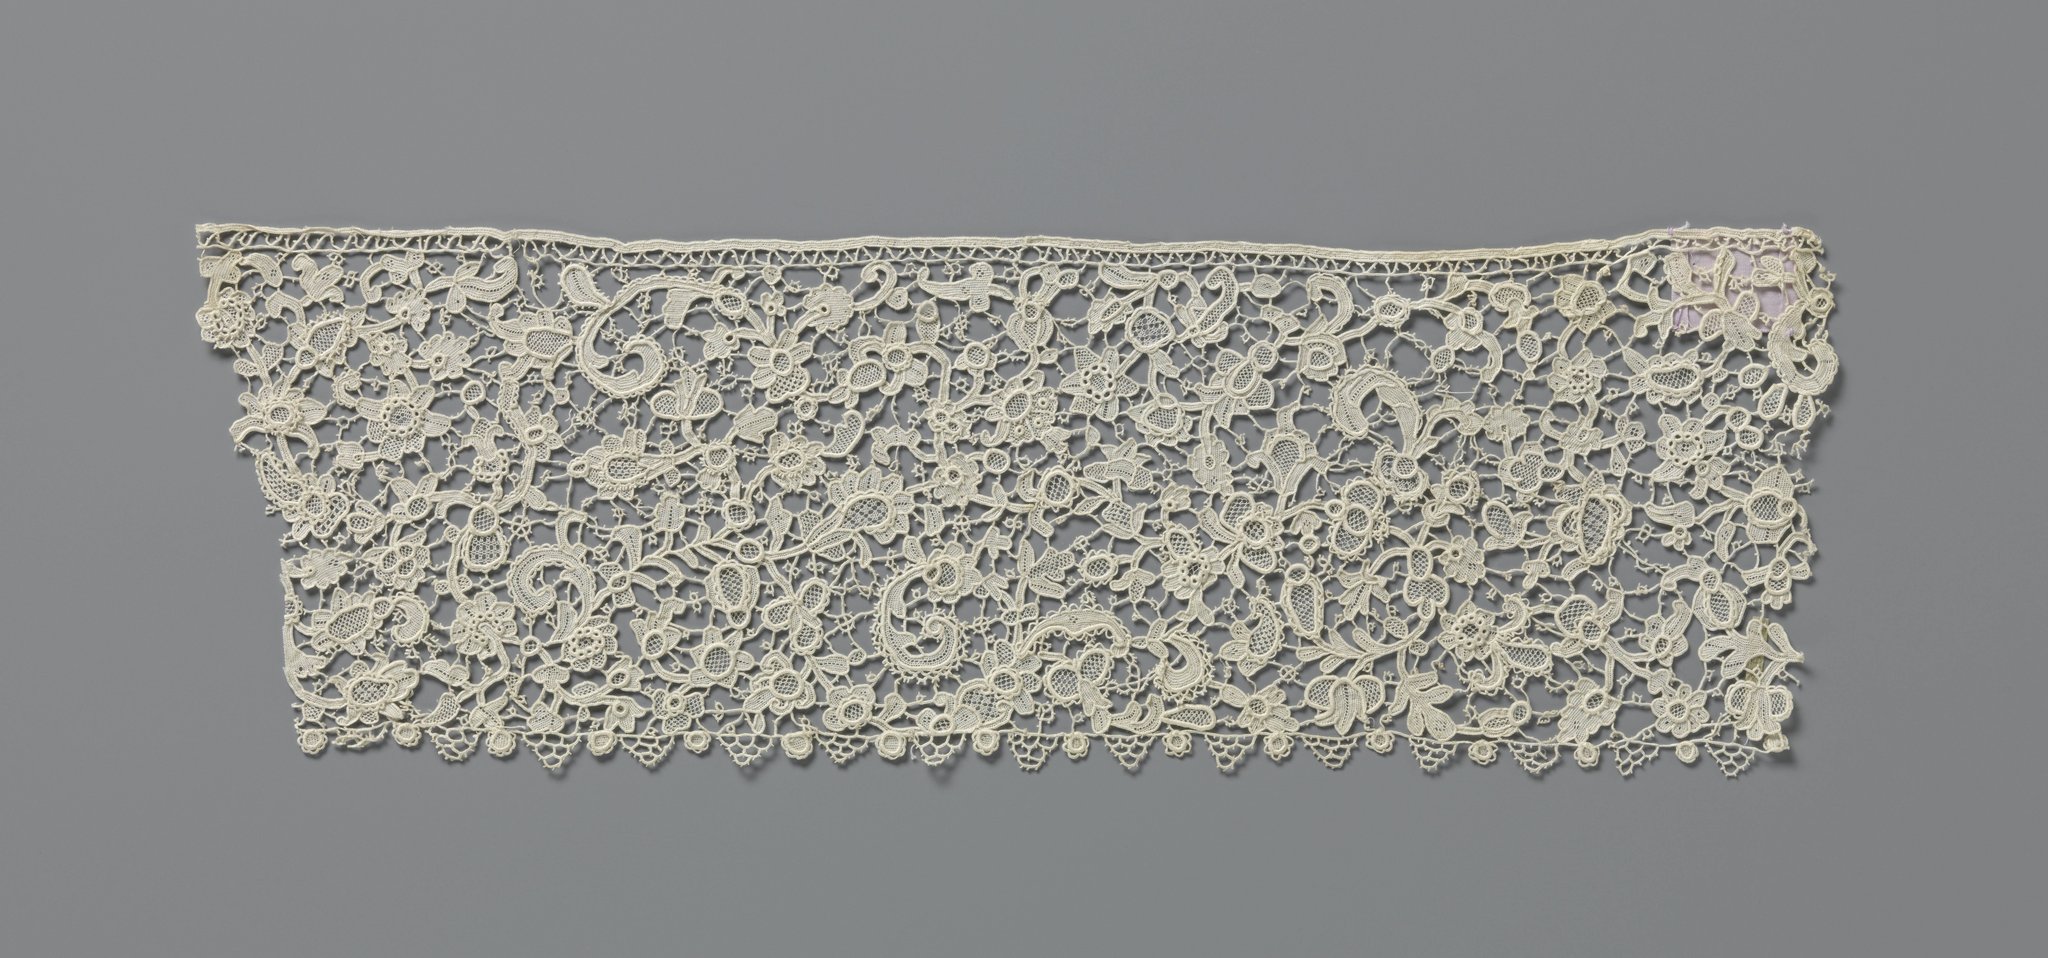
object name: strip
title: Strook naaldkant met c-voluten en veelsoortige bloemen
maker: Anonymous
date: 1900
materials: linen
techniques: rose point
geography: belgium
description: Strook naturelkleurig naaldkant: Venetiaanse rozenkant. Patroon met ranken met c-voluten en veelsoortige bloemen, zonder repetitief motief. Onregelmatige open grond met gepicoteerde spijlen. Volwerk met uitsparingen en veel verschillende siergronden. De bovenzijde is afgewerkt met een rechte rand met daaronder een gepicoteerde zigzaglijn. De onderzijde is afgewerkt met een rechte picotrand met driehoekjes en rozetbloempjes.